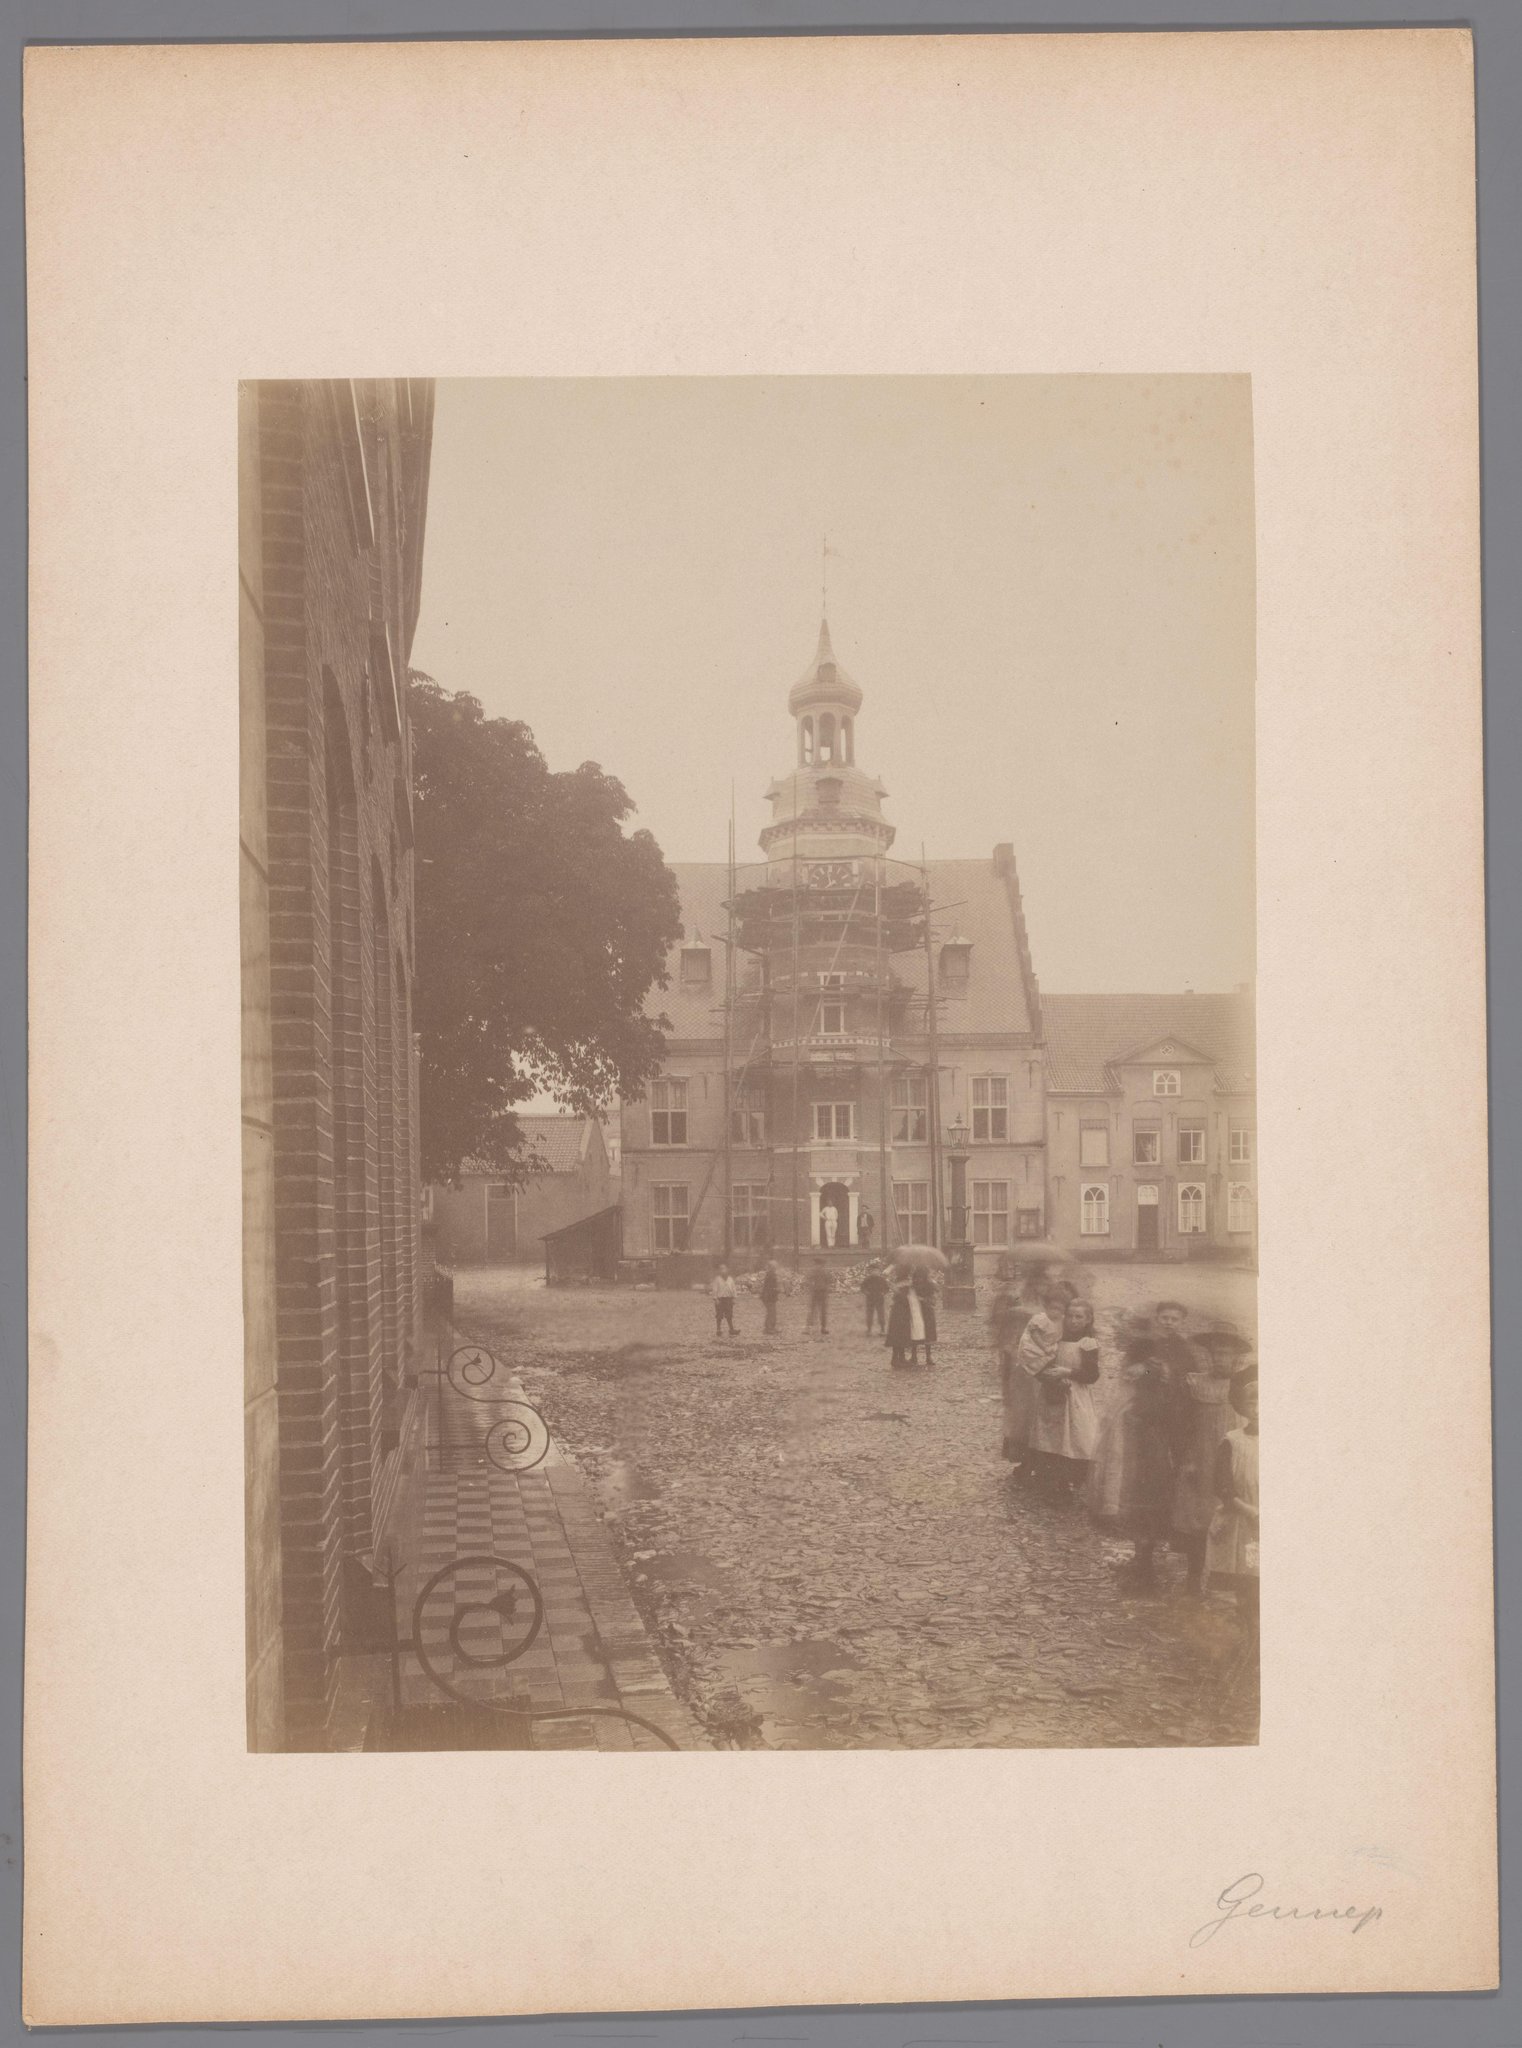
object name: photograph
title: Gezicht op het marktplein en stadhuis te Gennep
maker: anoniem (monumentenzorg)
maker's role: fotograaf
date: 1904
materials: cardboard, photographic support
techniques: albumen print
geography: gennep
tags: square, place, circus, etc., townhall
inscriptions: annotation: ‘Raadhuis Gennep (L.)/ oct 1904’, annotation: ‘Gennep’